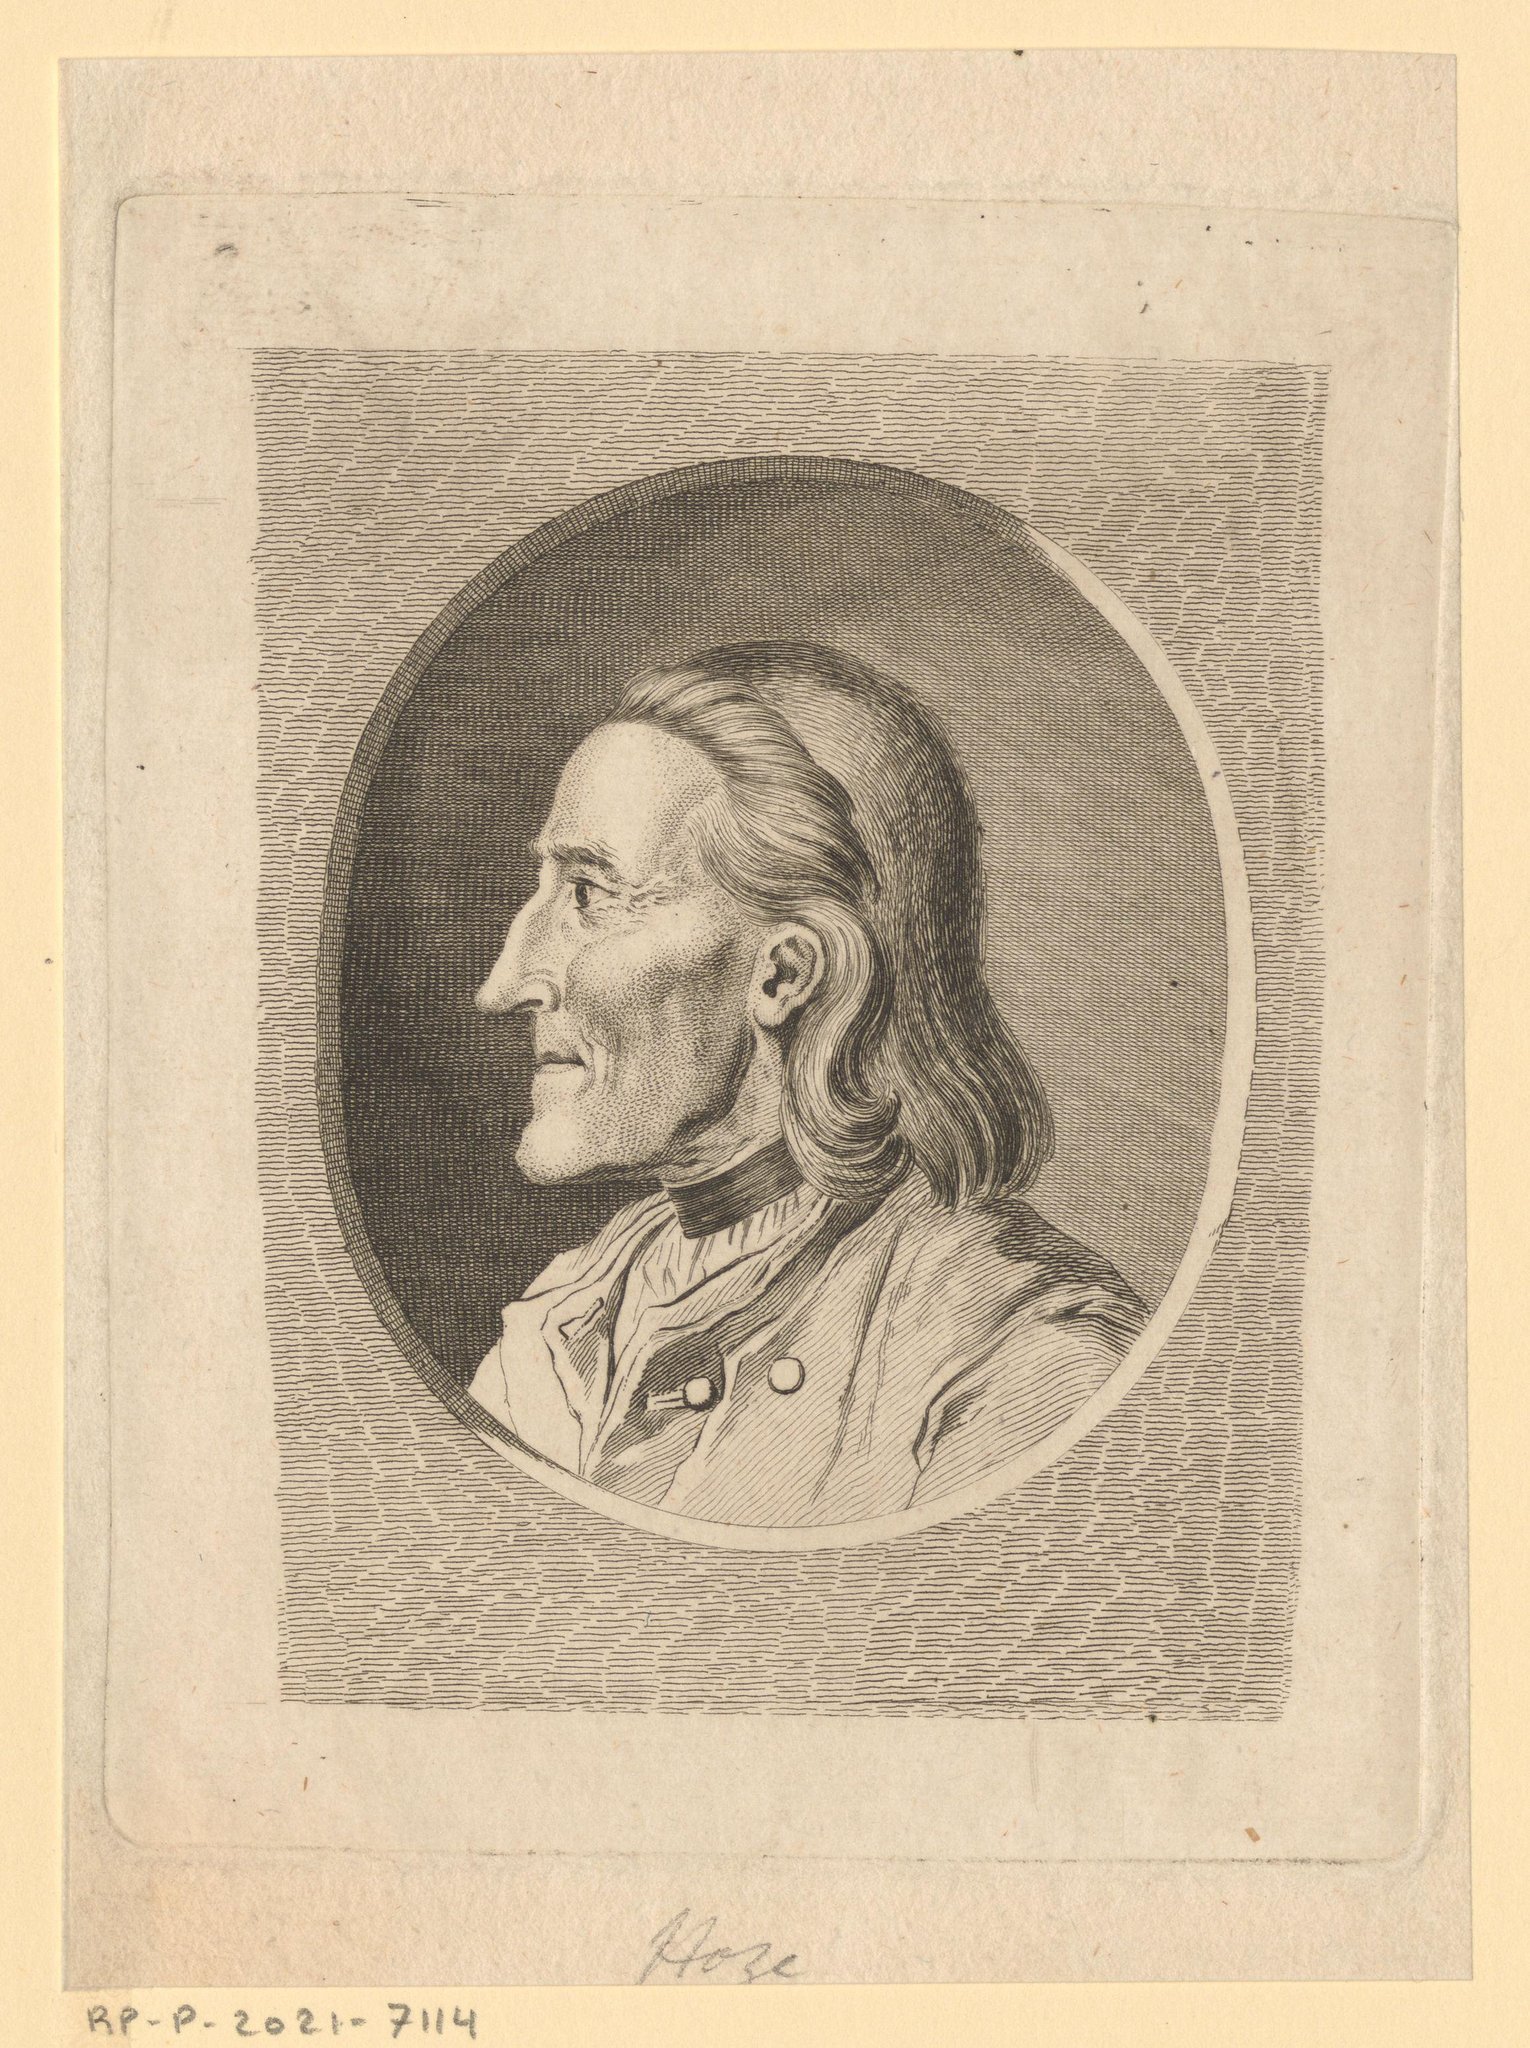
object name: print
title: Portret van een man aangeduid als Hoze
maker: Anonymous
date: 1775-1799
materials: paper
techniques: etching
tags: historical persons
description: Mogelijk Friedrich von Hotze (1739-1799).